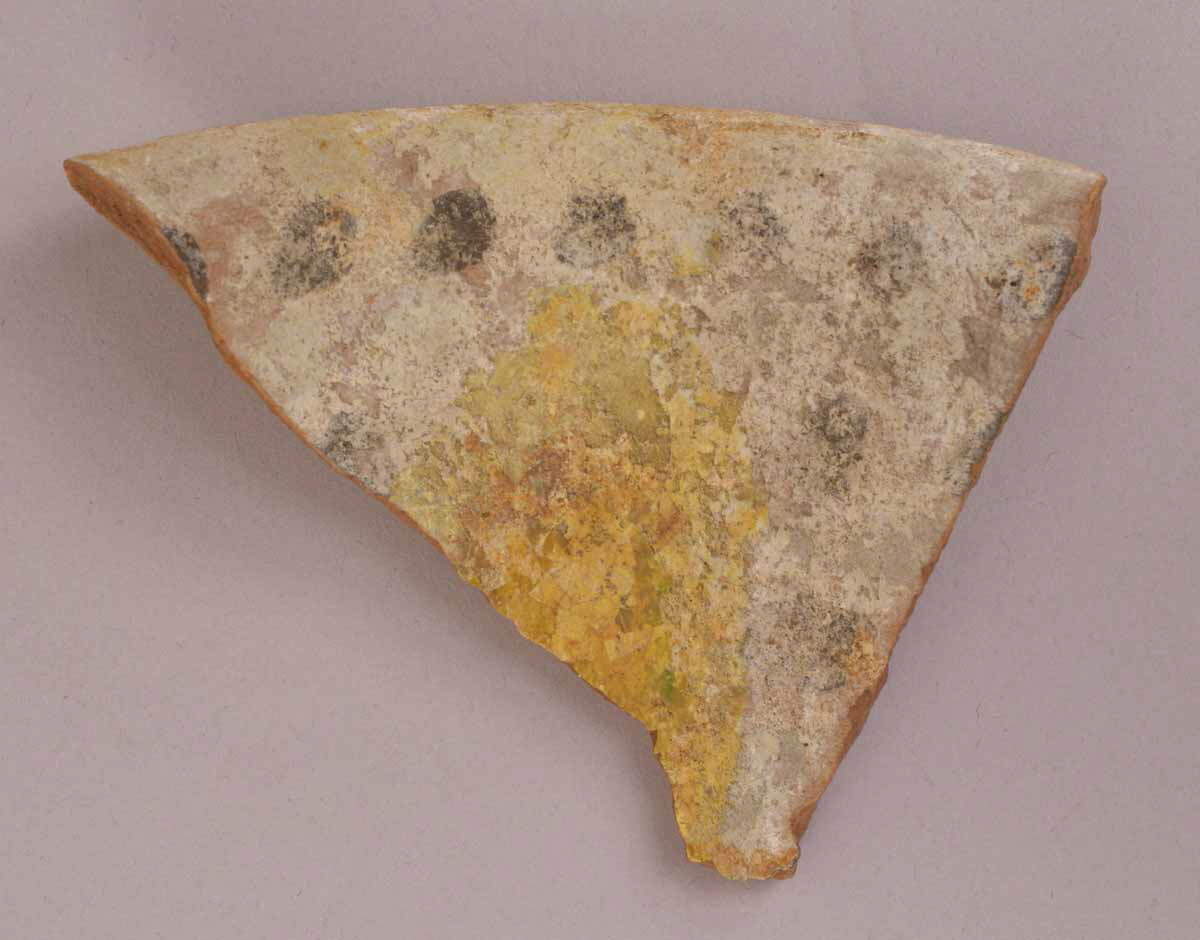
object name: fragment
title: Ceramic Fragment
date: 701-900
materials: earthenware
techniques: glazing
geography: iraq